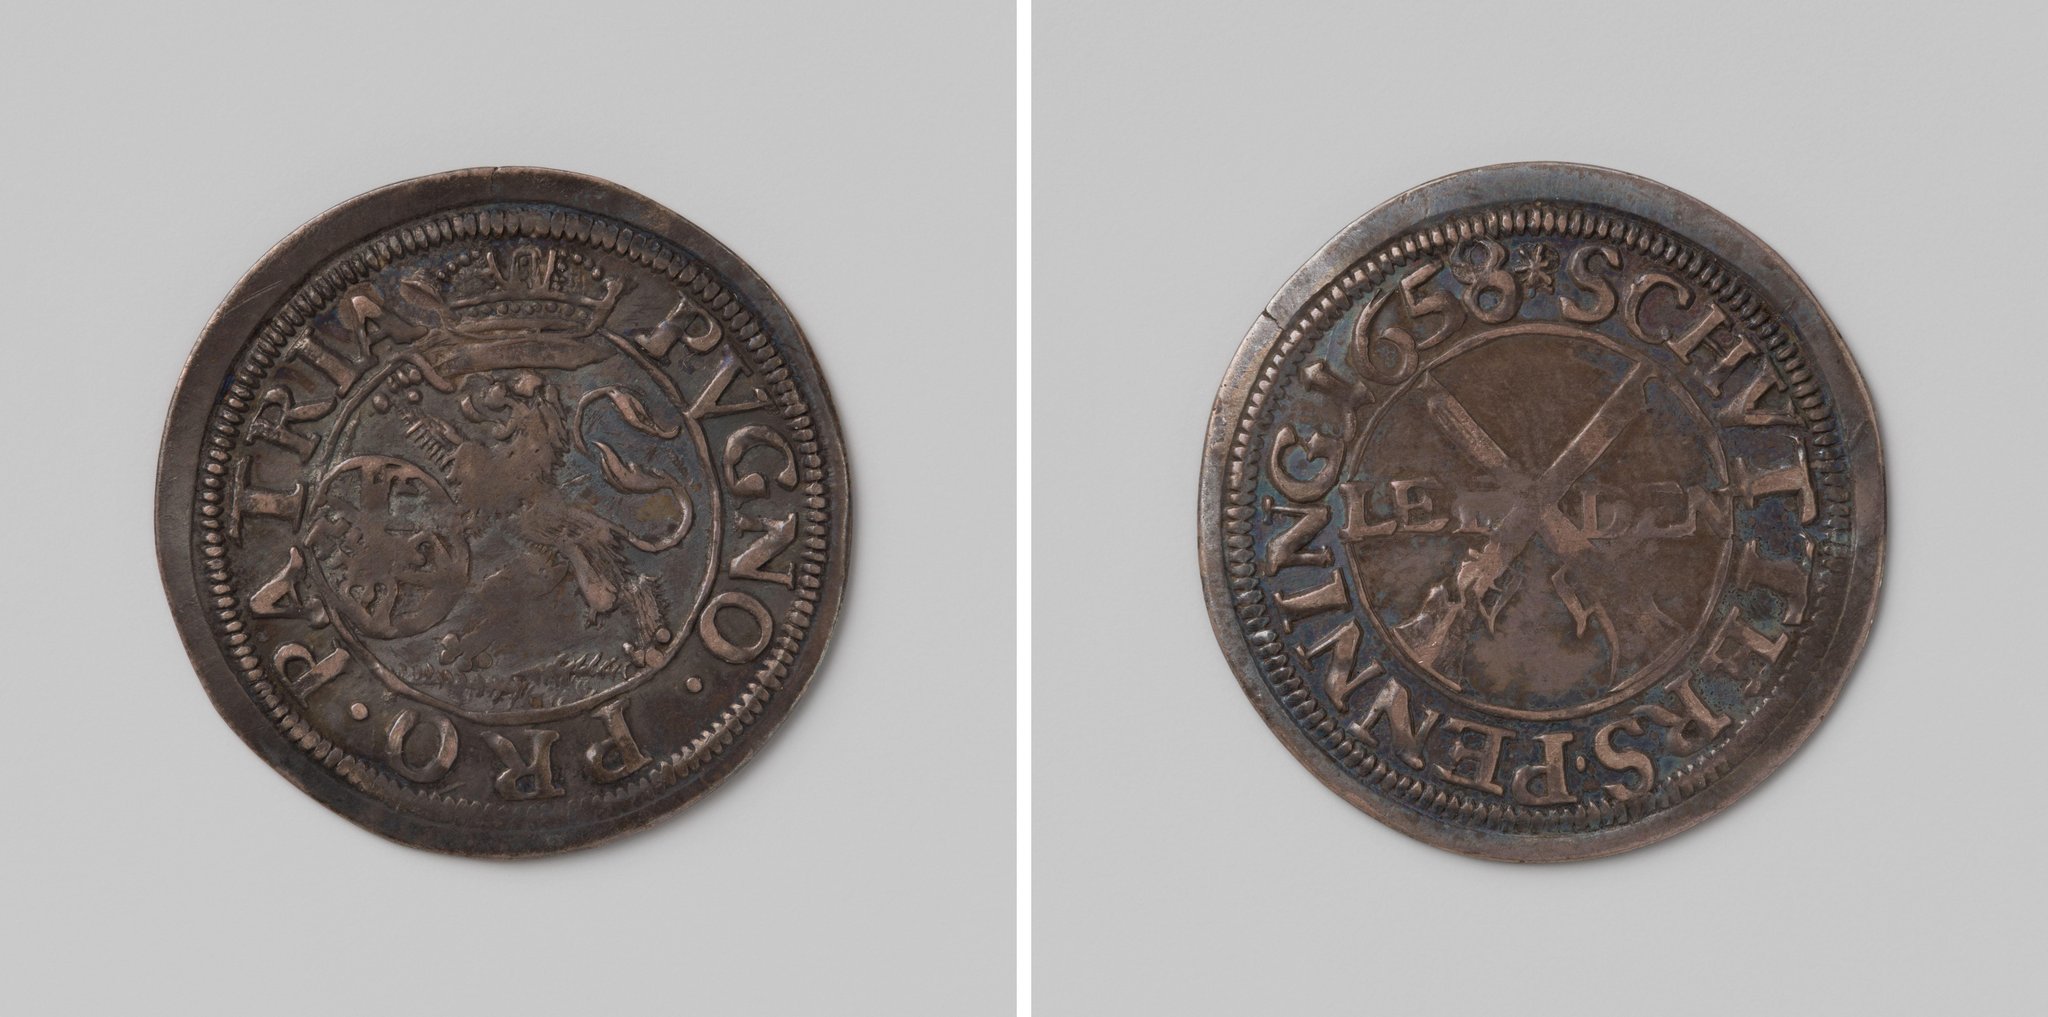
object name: marksman medal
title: Schutterij van Leiden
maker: Anonymous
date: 1658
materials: silver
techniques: striking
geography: leiden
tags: leiden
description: Zilveren penning. Voorzijde: leeuw met zwaard in boven hoofd geheven rechterklauw en schild in linkerklauw onder kroon binnen omschrift. Keerzijde: twee gekruiste musketten tussen opschrift binnen omschrift